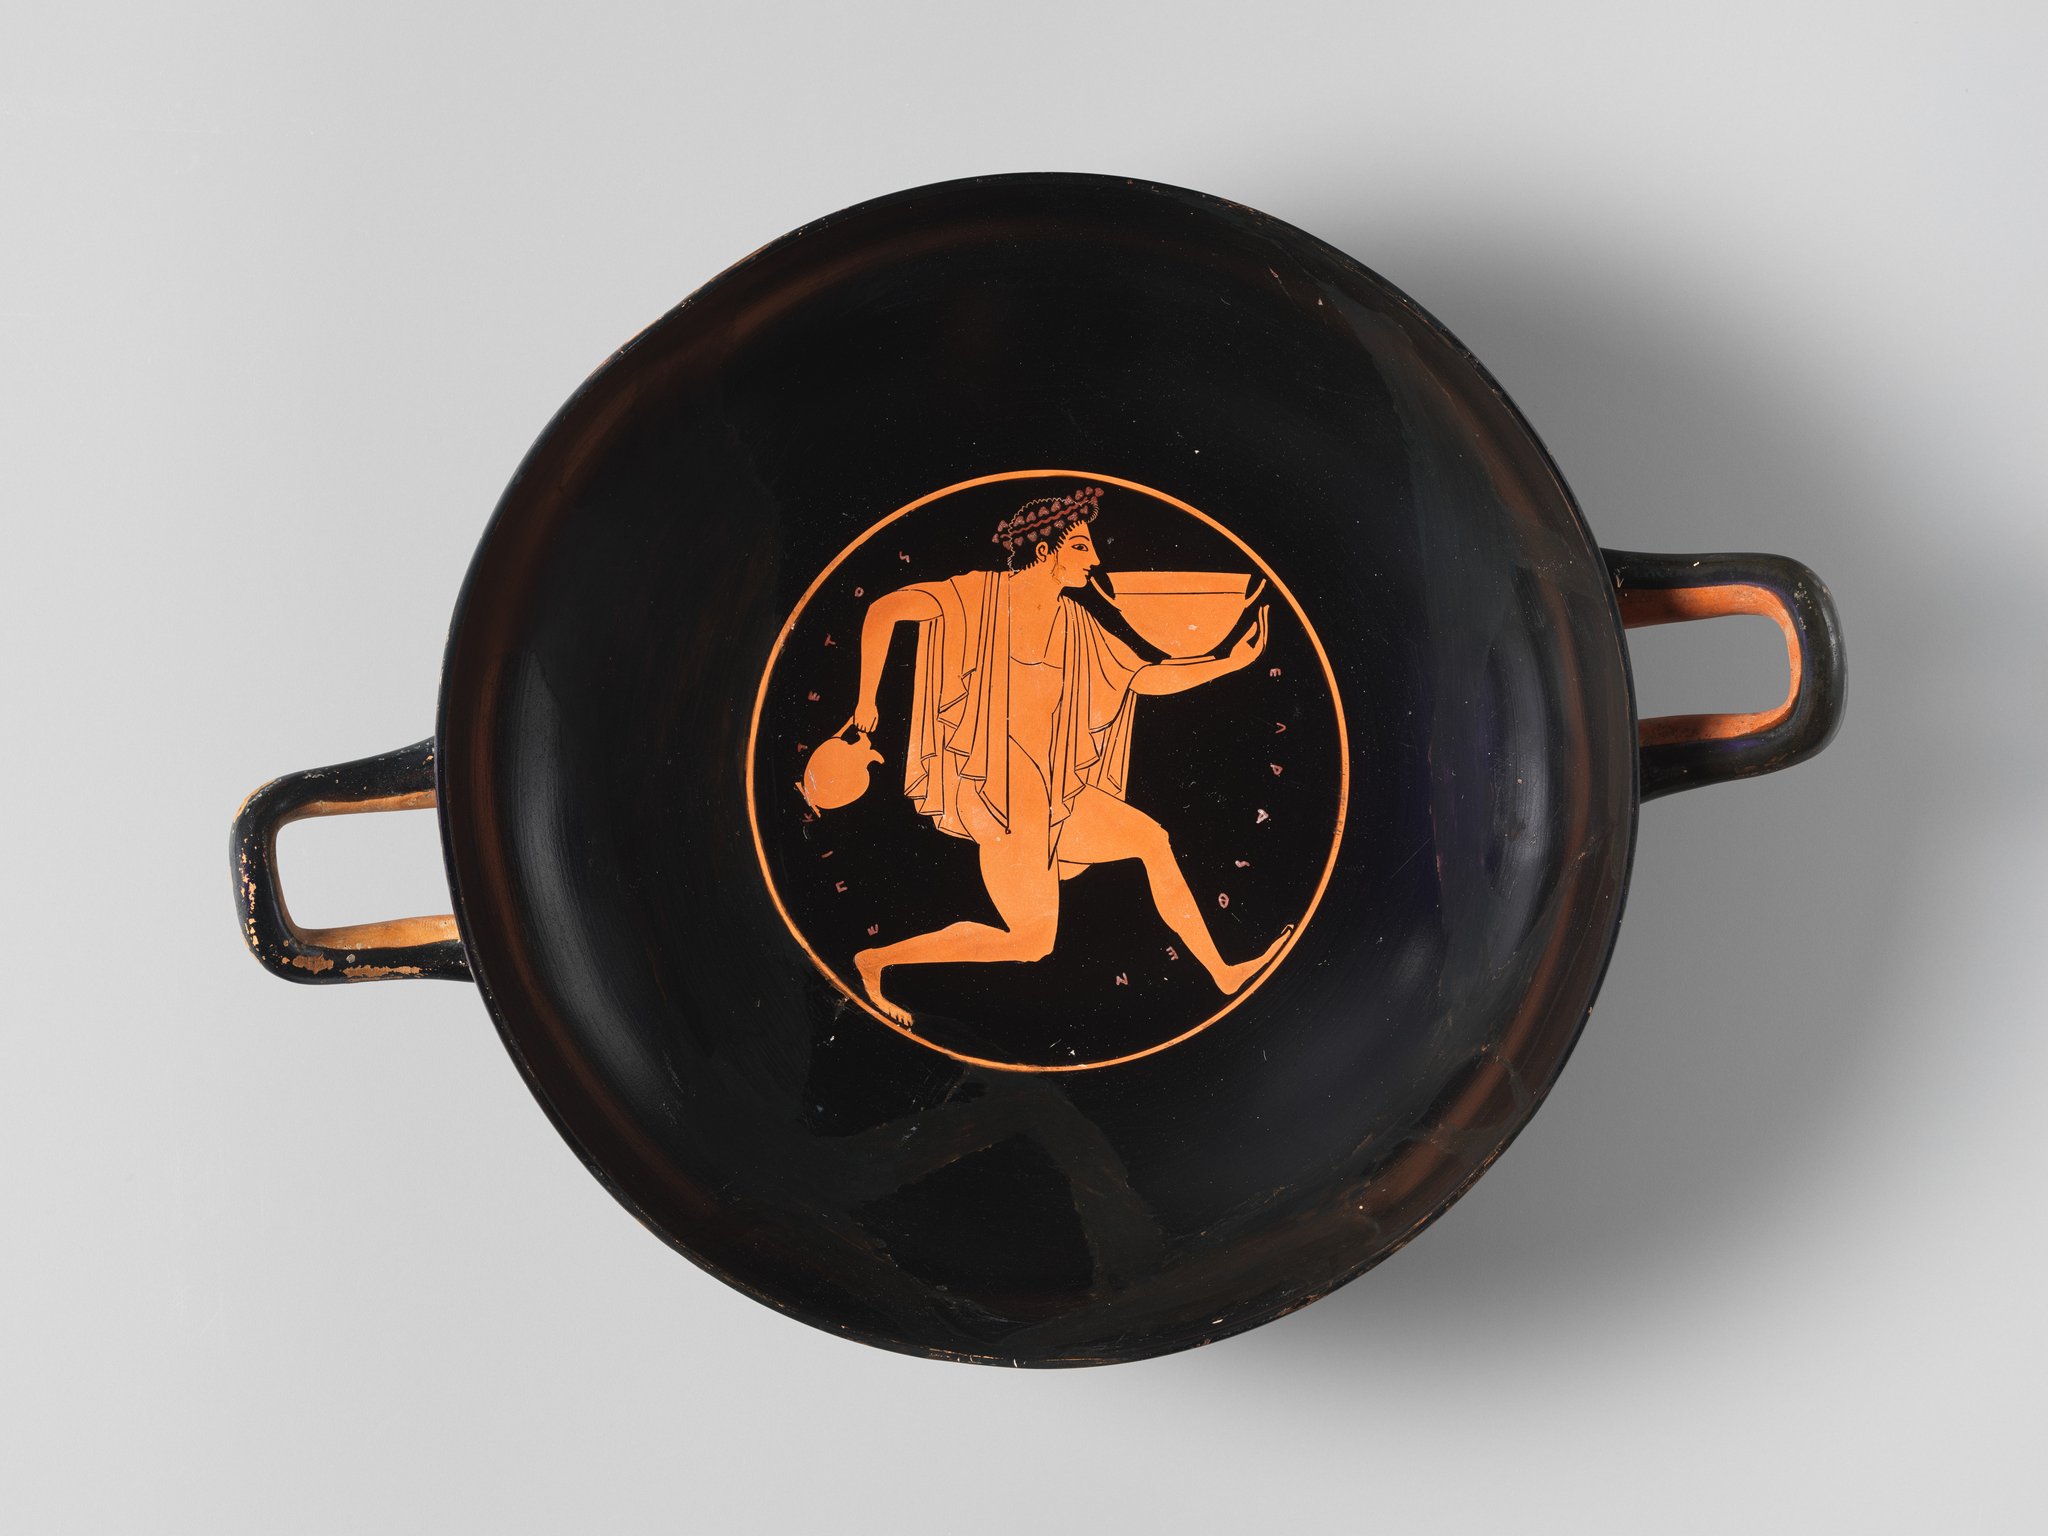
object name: kylix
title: Terracotta kylix (drinking cup)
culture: greek, attic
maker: epiktetos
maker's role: artist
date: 510 BCE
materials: terracotta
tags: men